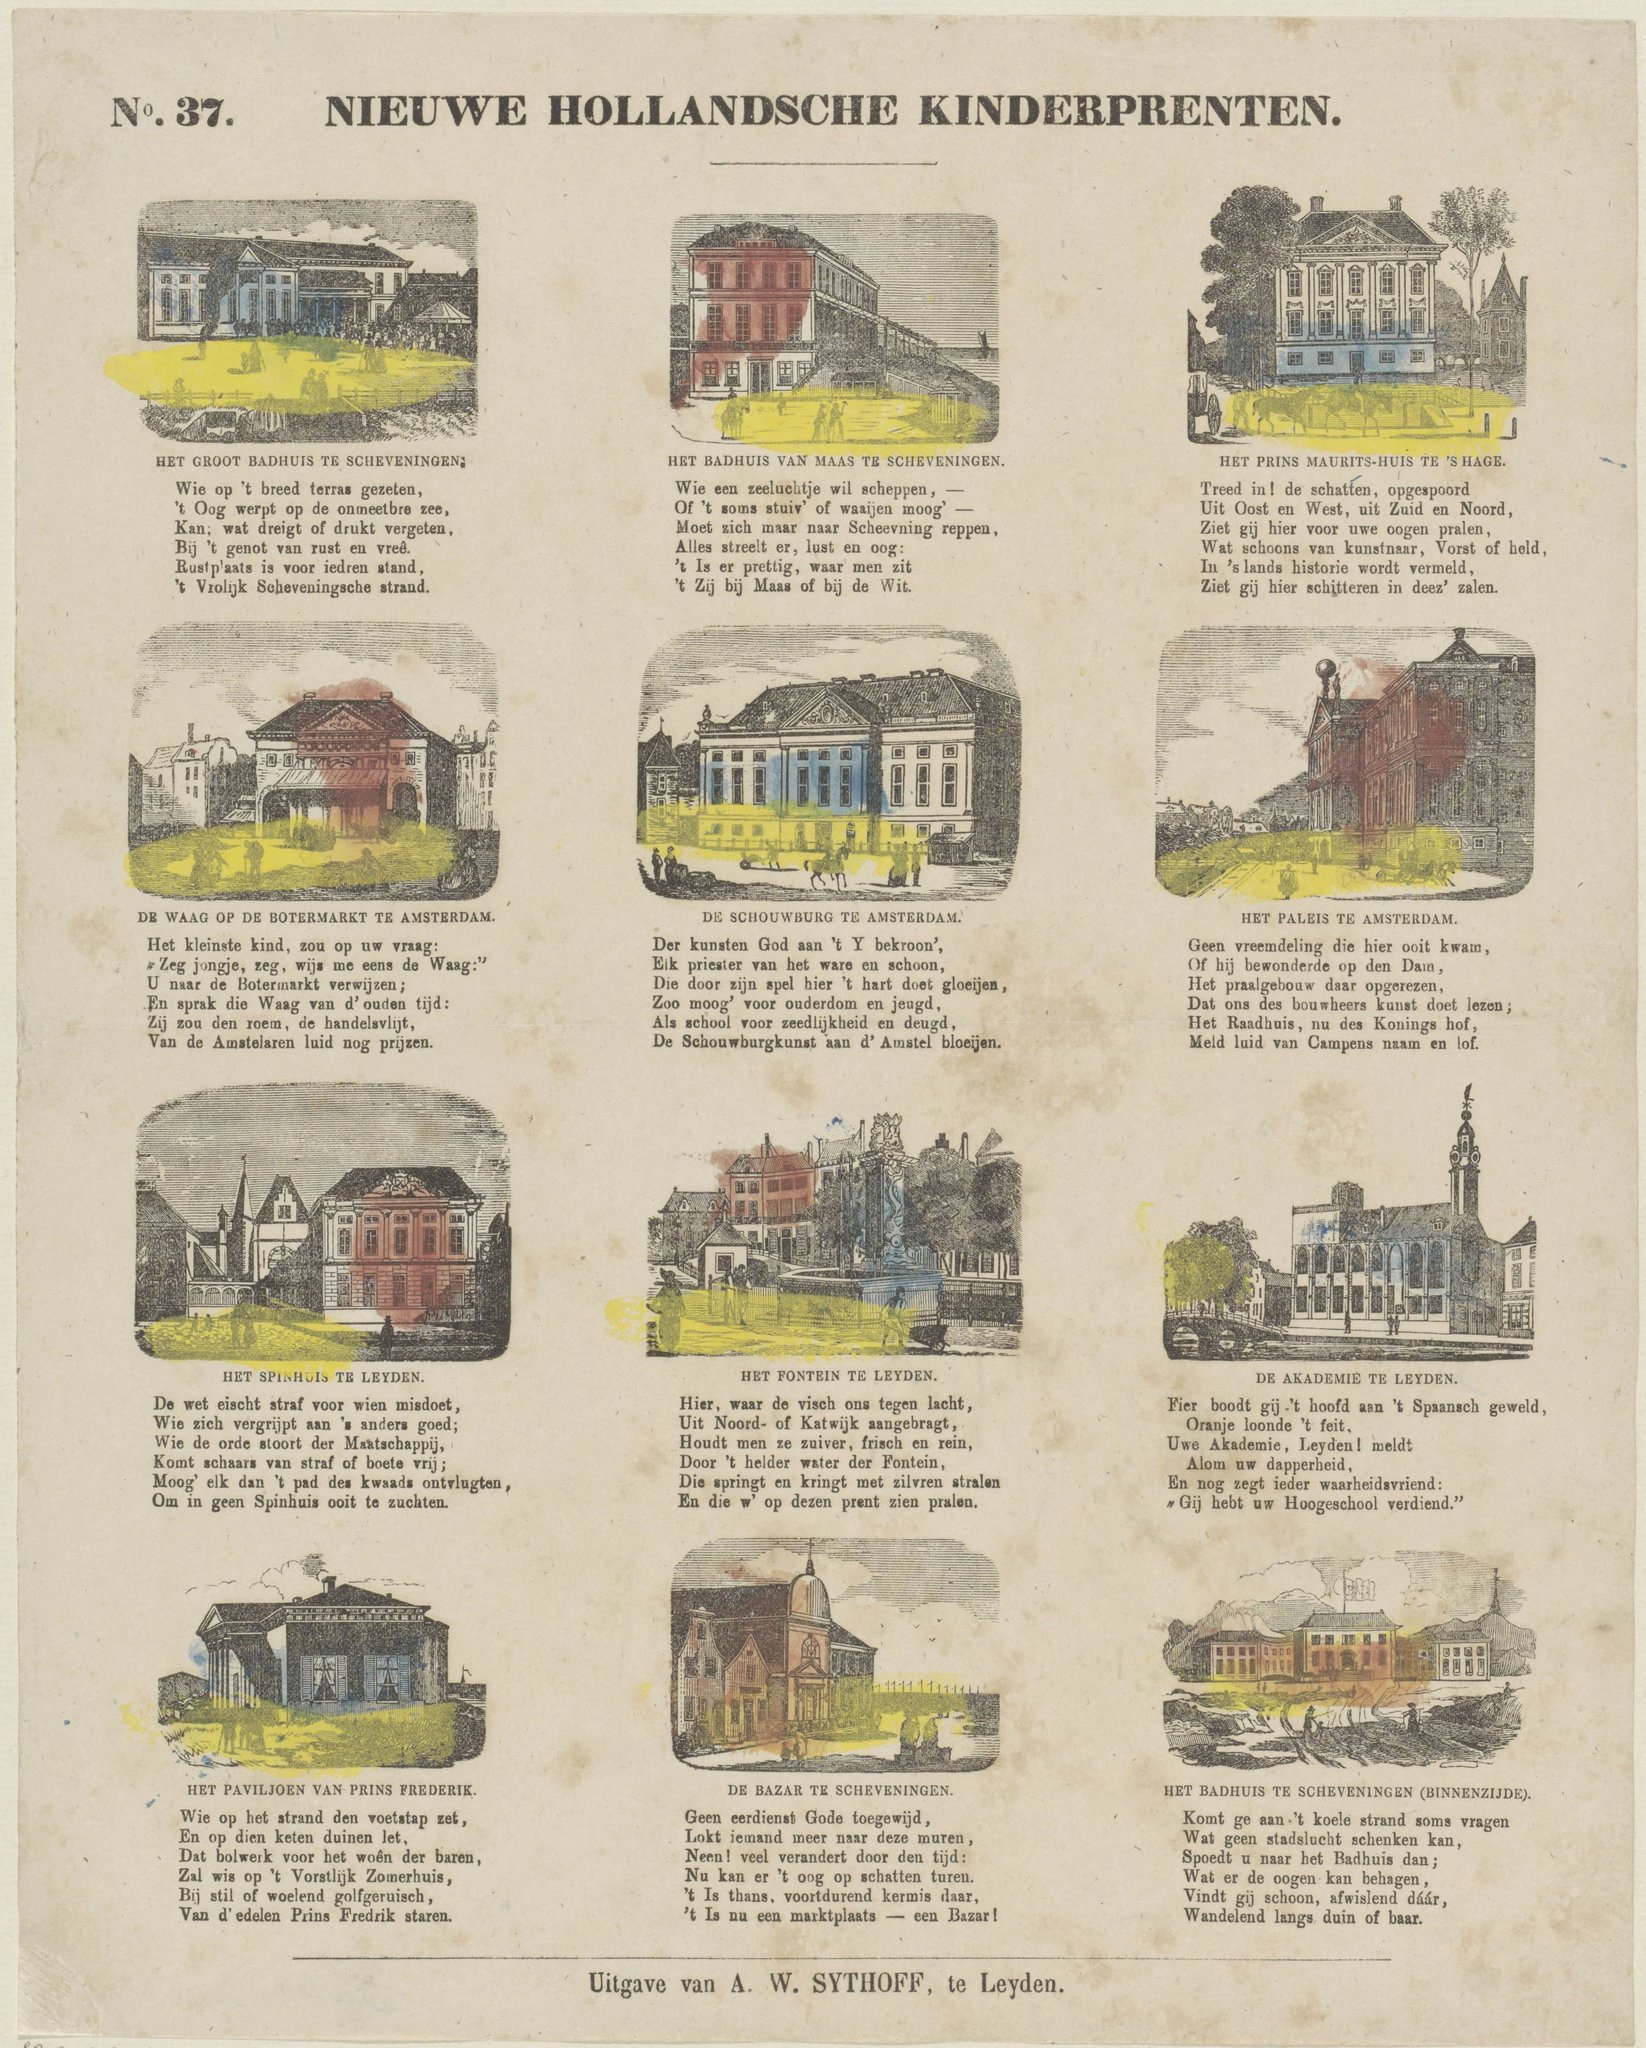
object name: print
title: Nieuwe Hollandsche kinderprenten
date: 1861-1929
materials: paper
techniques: colour, letterpress printing, engraving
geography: leiden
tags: palace, public baths, theatre (building), leiden, the hague, royal palace of amsterdam, amsterdam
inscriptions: inscription: ‘Pieter Leidekker’, collector's mark: Lugt 2760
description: Blad met 12 voorstellingen van bekende gebouwen in Nederland, zoals het Mauritshuis in Den Haag, de Waag op de Botermarkt in Amsterdam en het Paleis op de Dam in Amsterdam. Onder elke voorstelling een titel en een zesregelig vers. Genummerd linksboven: No. 37.